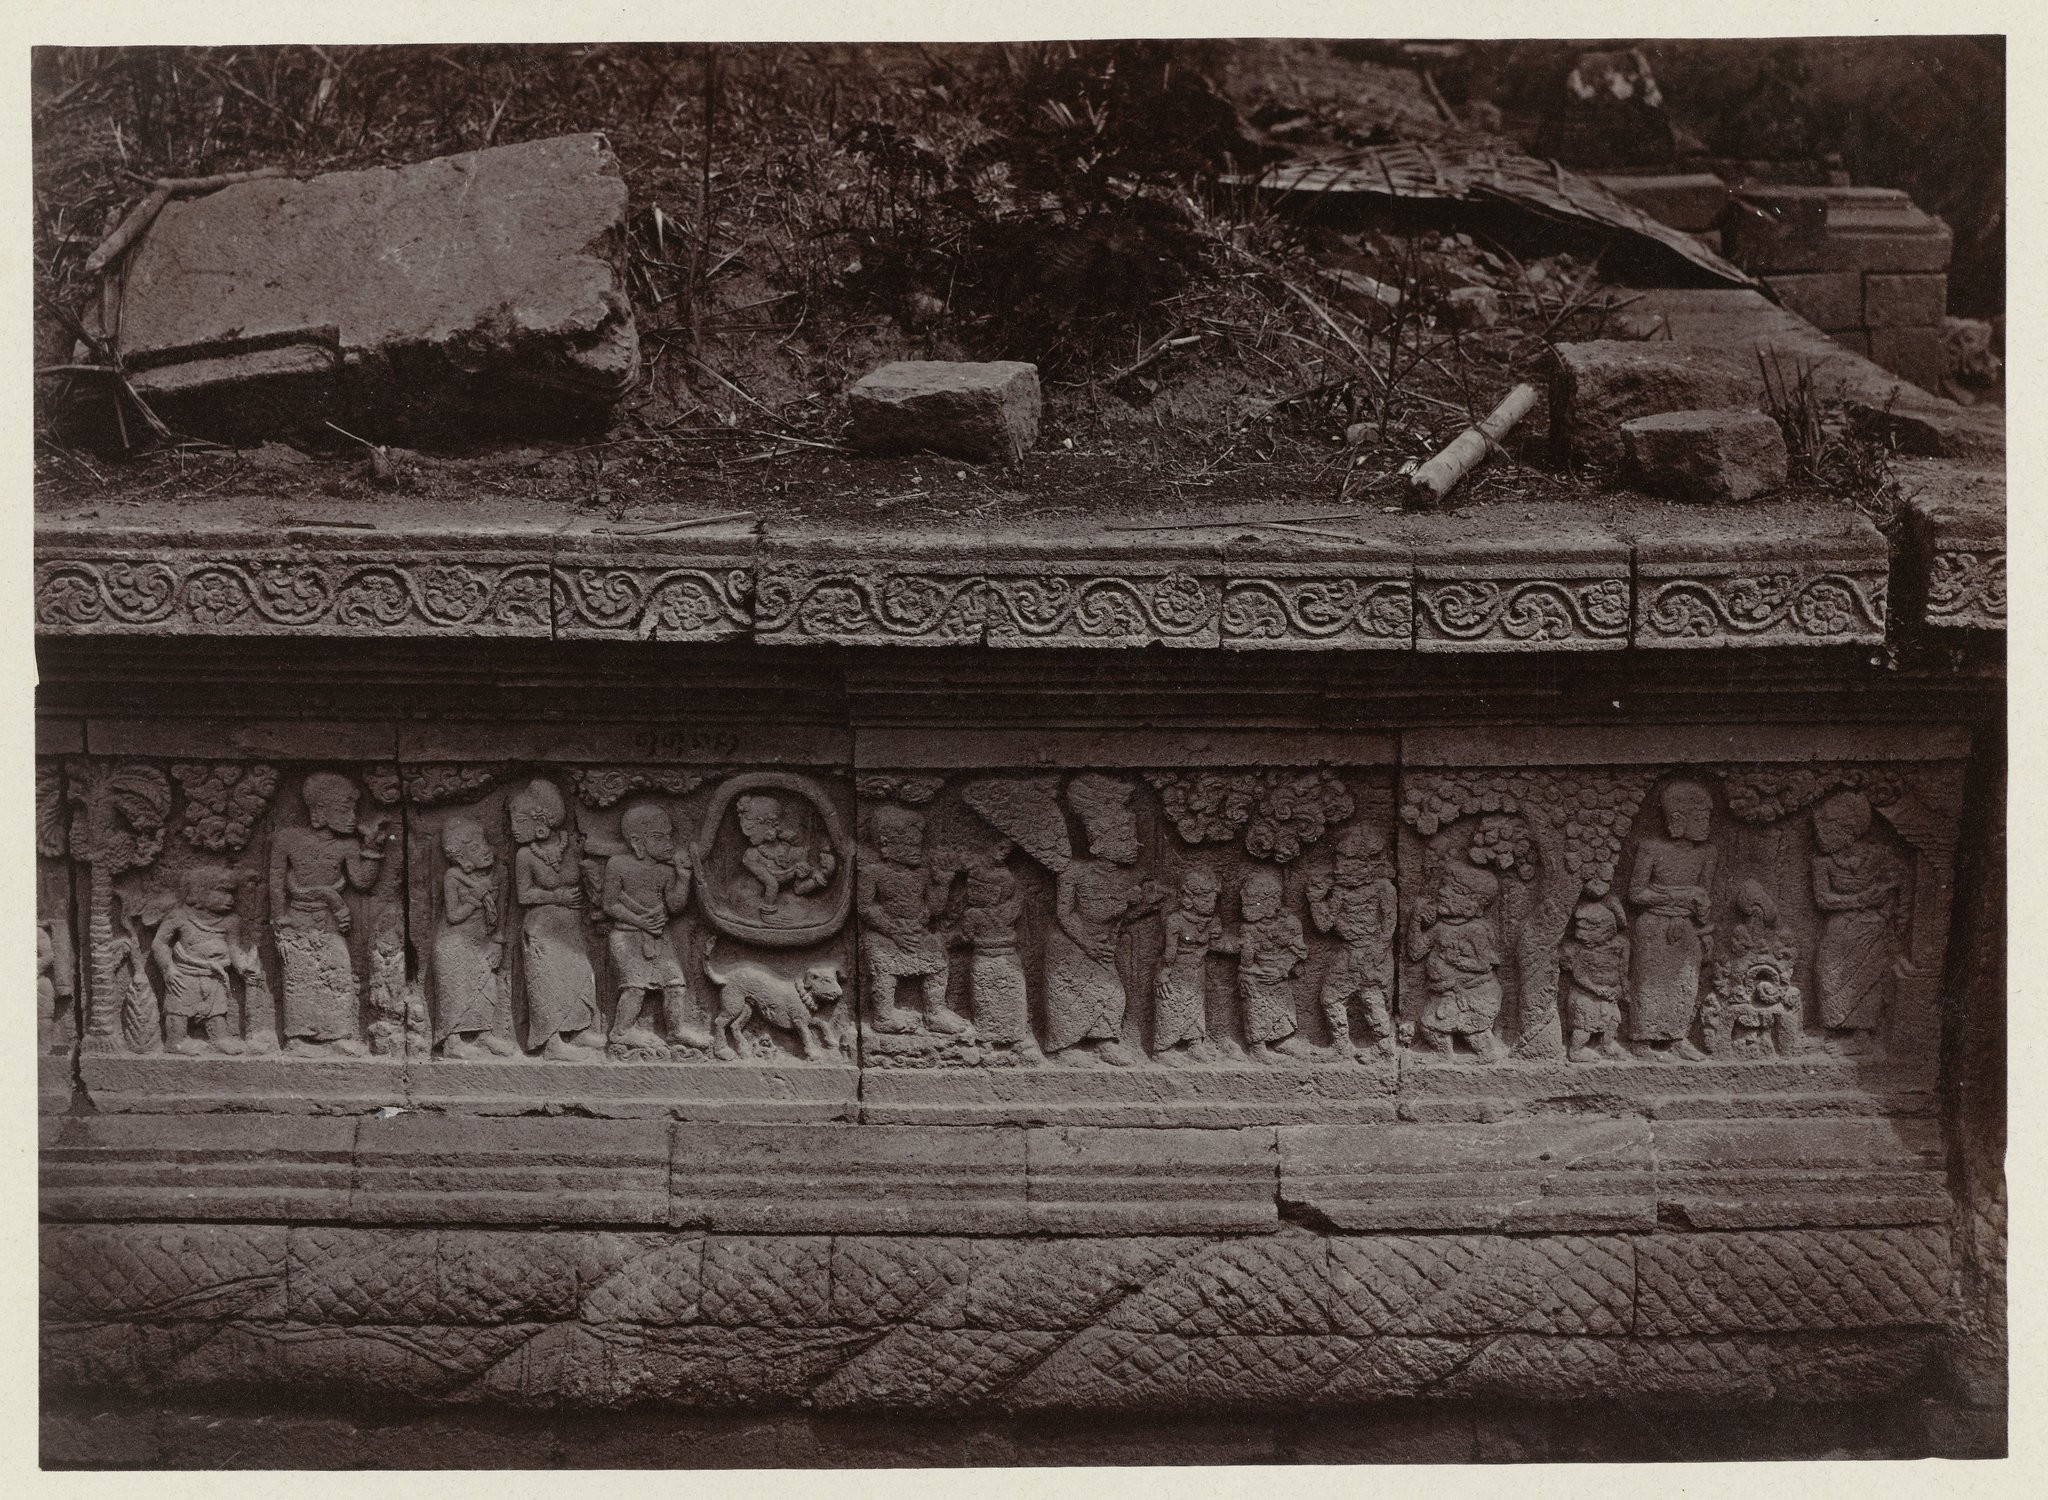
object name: photograph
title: Basreliëf op het pendopo voetstuk aan de noordzijde van Candi Panataran.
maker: isidore kinsbergen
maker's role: fotograaf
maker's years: 1821-1905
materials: cardboard, paper, photographic support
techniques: albumen print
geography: java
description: Candi Panataran (Temple Complex), Pendopo Terrace, unidentified reliefs 44-46 (inscription above no. 45 reads tuturan), north side. Panataran, Blitar district, East Java province, 1375 AD